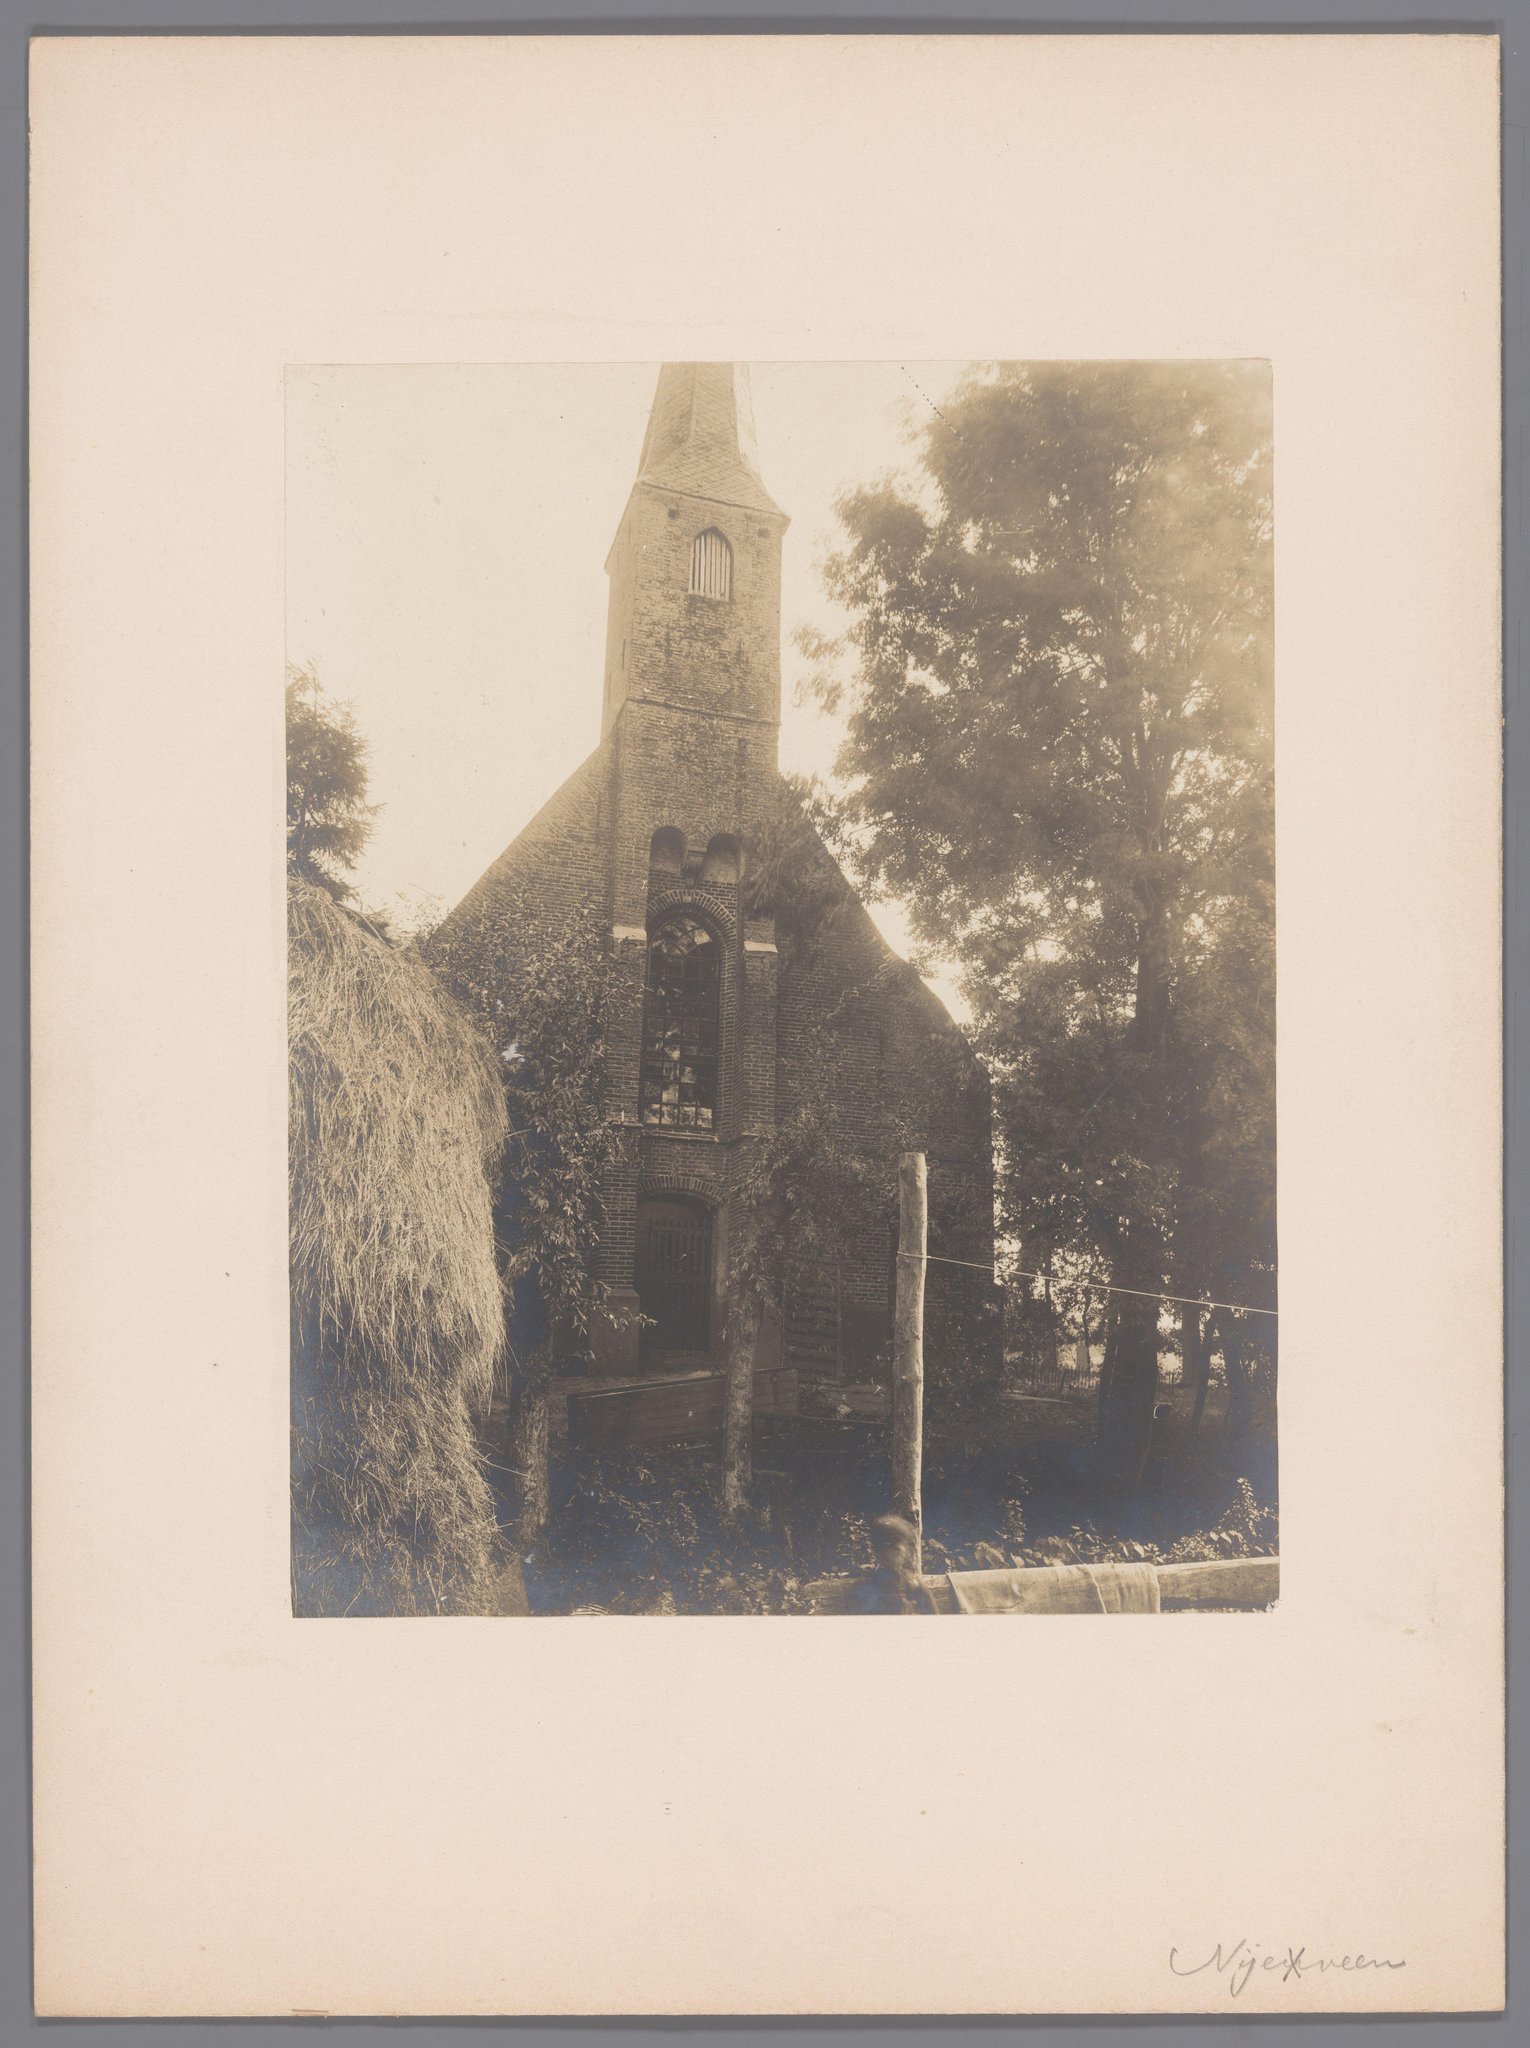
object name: photograph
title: Gezicht op de Hervormde Kerk te Nijeveen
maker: anoniem (monumentenzorg)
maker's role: fotograaf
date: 1906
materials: cardboard, photographic support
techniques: gelatin silver print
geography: nijeveen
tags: church (exterior)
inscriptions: annotation: ‘Nijeveen’, annotation: ‘Nijeveen Drenthe/ sept 1906’